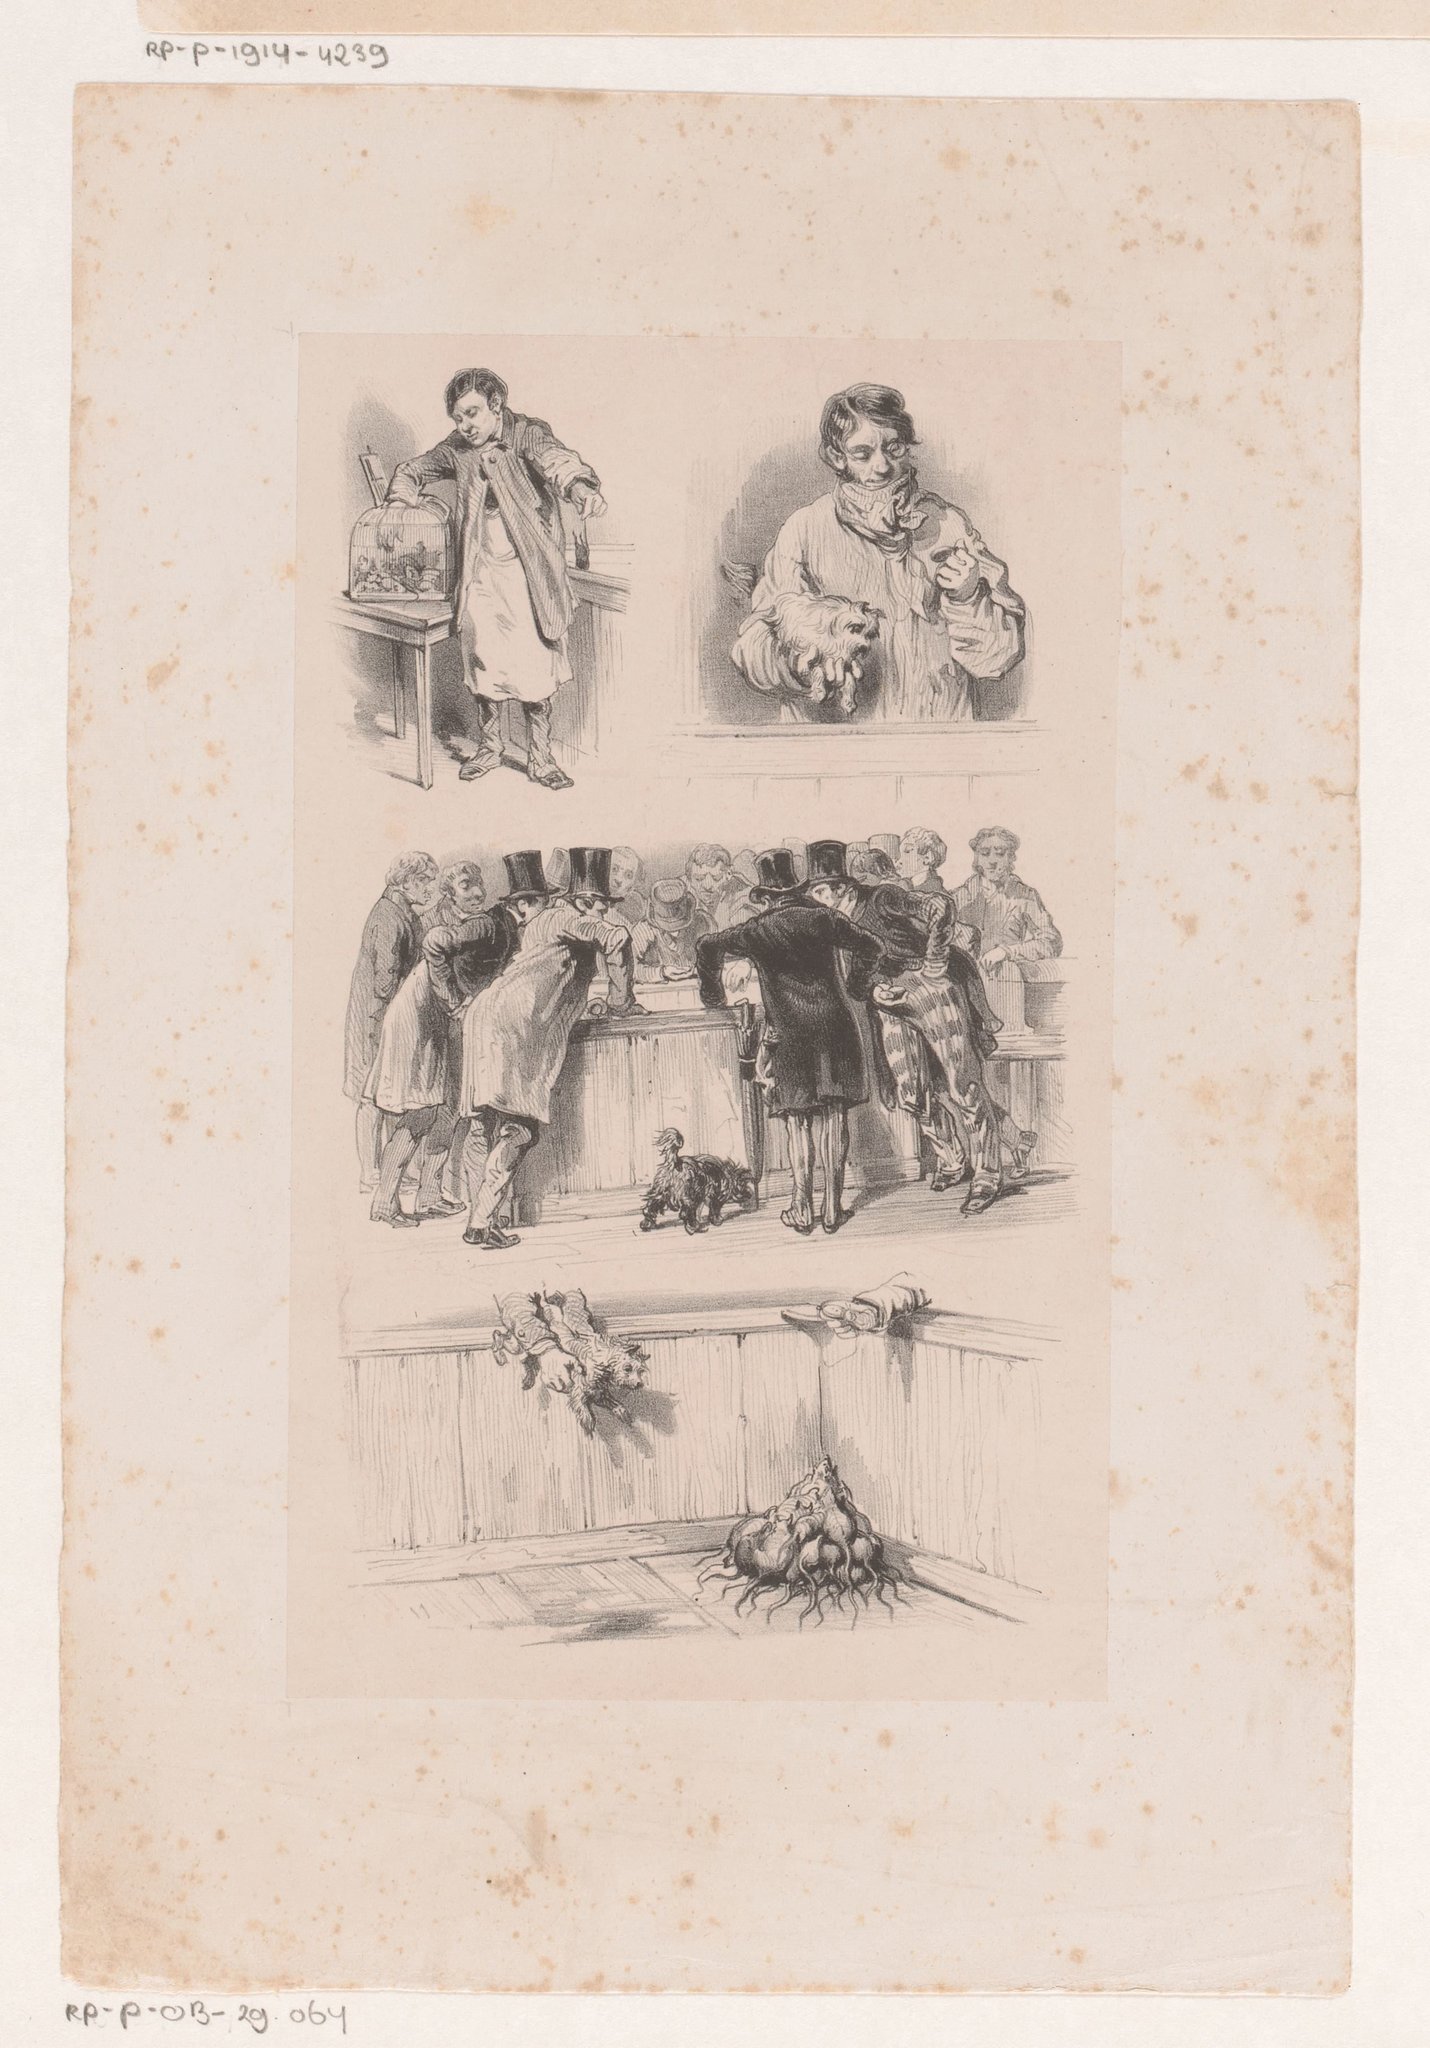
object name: print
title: Scènes met hond en ratten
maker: carel christiaan antony last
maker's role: print maker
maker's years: 1808-1876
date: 1818-1876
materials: paper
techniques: lithograph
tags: eradication of mice, betting, dog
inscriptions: collector's mark: Lugt 2228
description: Een man haalt muizen of ratten uit een kooi en plaatst ze binnen een houten omheining. Een andere man kijkt op zijn horloge met een hond op zijn arm. Mannen leunen over de houten omheining en kijken omlaag. De hond wordt bij de muizen gezet, een van de mannen kijkt op zijn horloge. Waarschijnlijk zijn er weddenschappen afgesloten over hoe lang het duurt voordat de hond de muizen heeft gevangen.